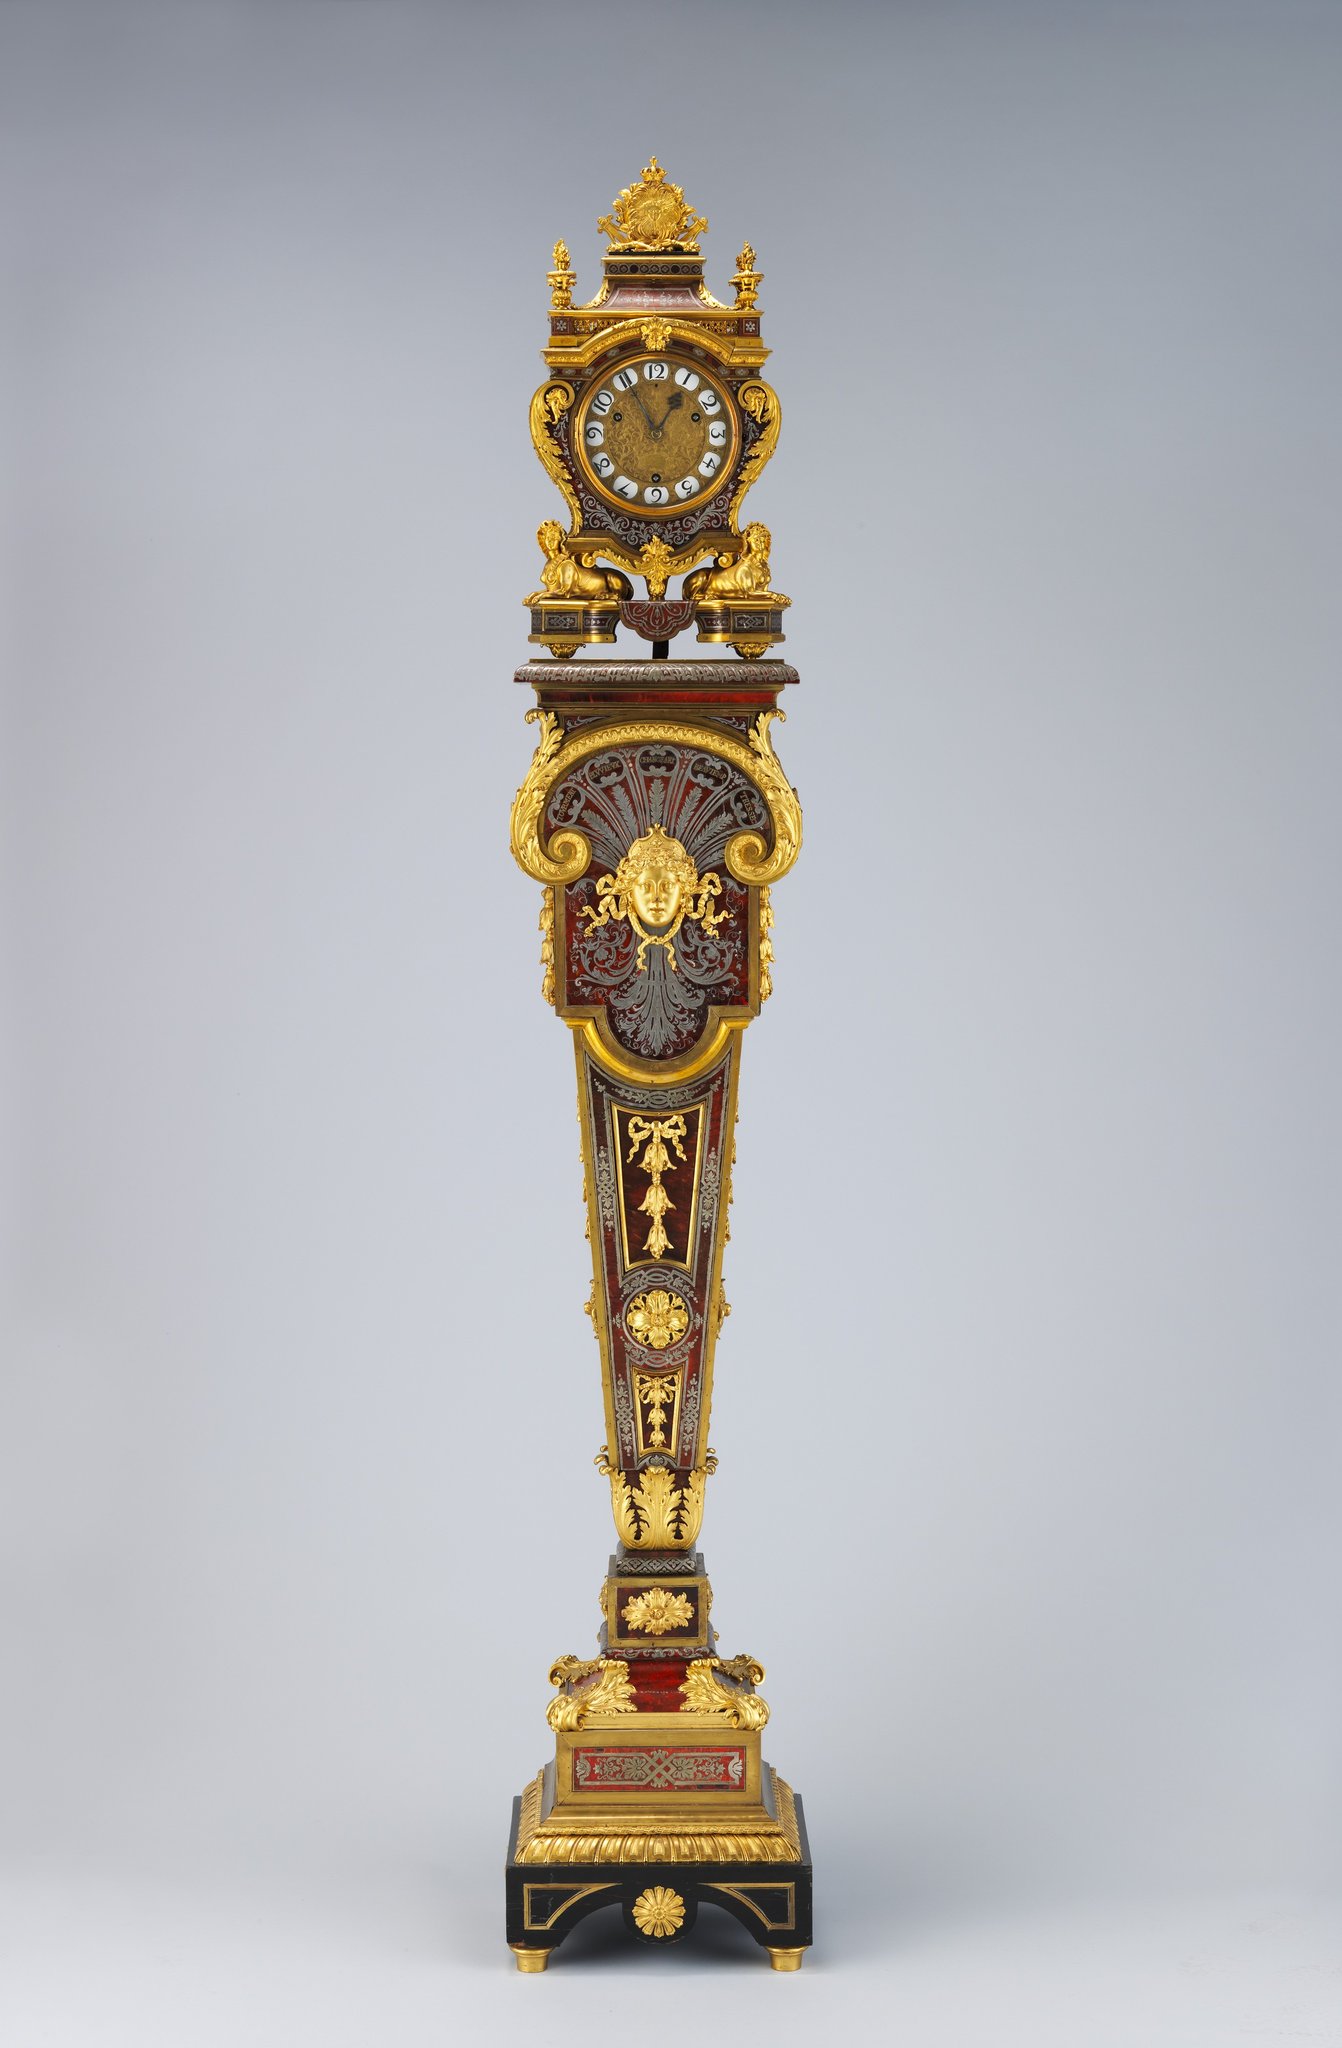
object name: clock with pedestal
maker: andré charles boulle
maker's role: maker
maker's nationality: french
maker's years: 1642-1732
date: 1690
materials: brass, gilt, gilt bronze, wood, pewter, steel, shell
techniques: enamel, engraving